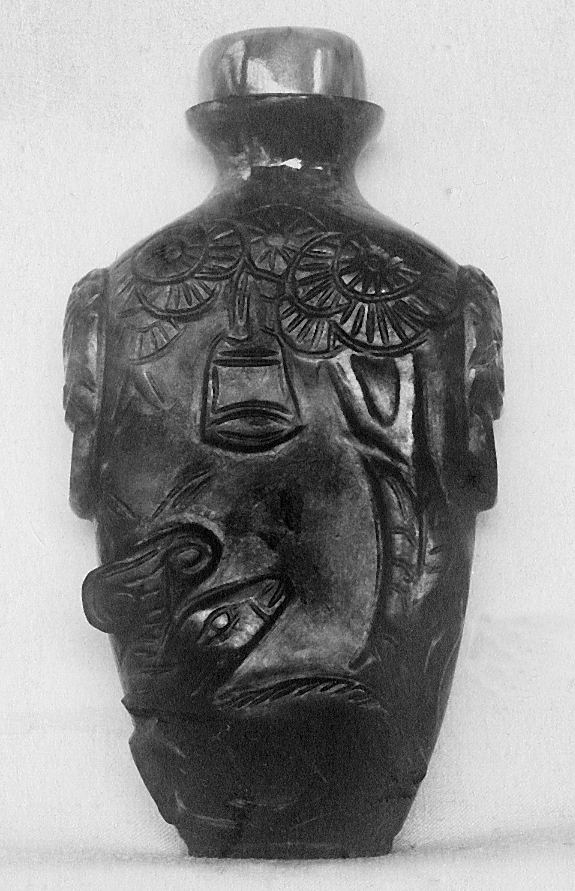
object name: snuff bottle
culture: chinese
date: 1801-1900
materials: jade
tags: animals